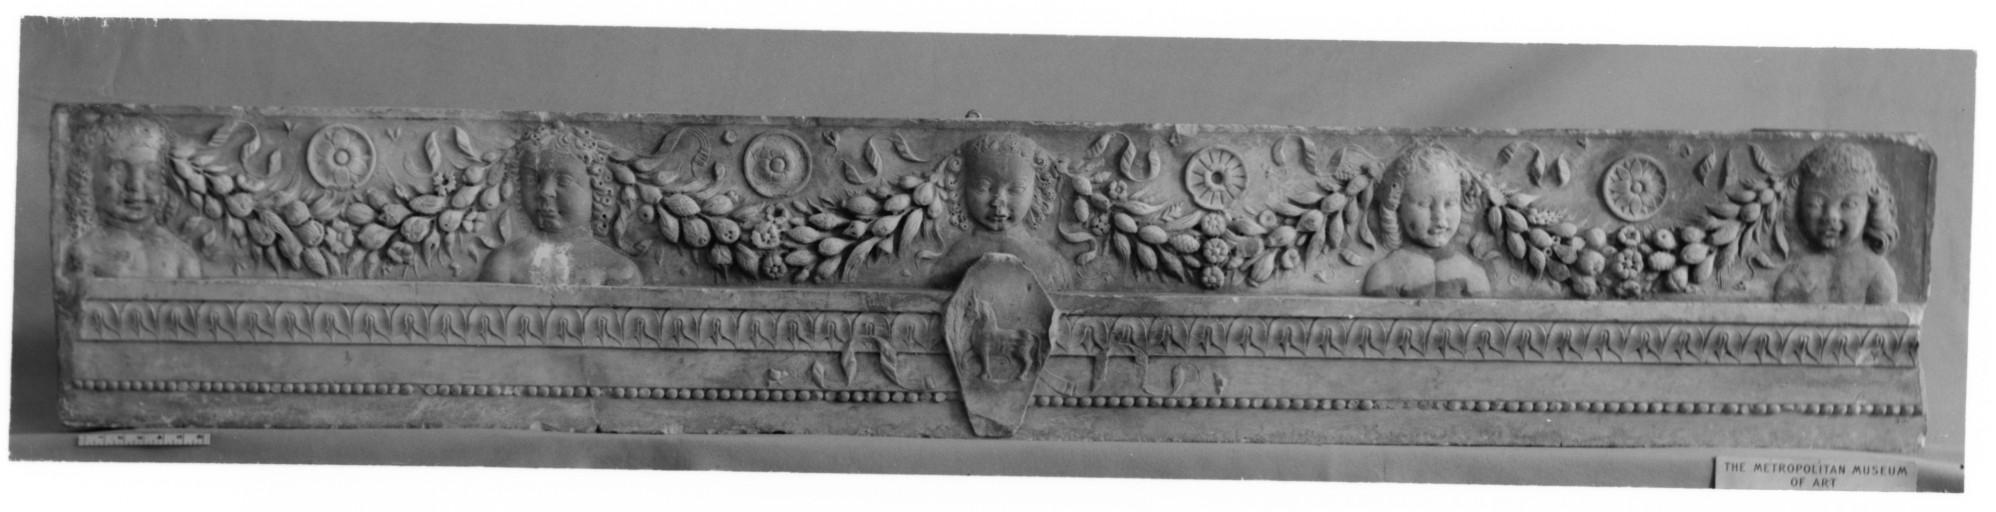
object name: frieze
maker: giovanni dalmata (giovanni duknovich di traù)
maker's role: maker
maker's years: 1440-1509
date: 1451-1500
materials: marble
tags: garlands,heads